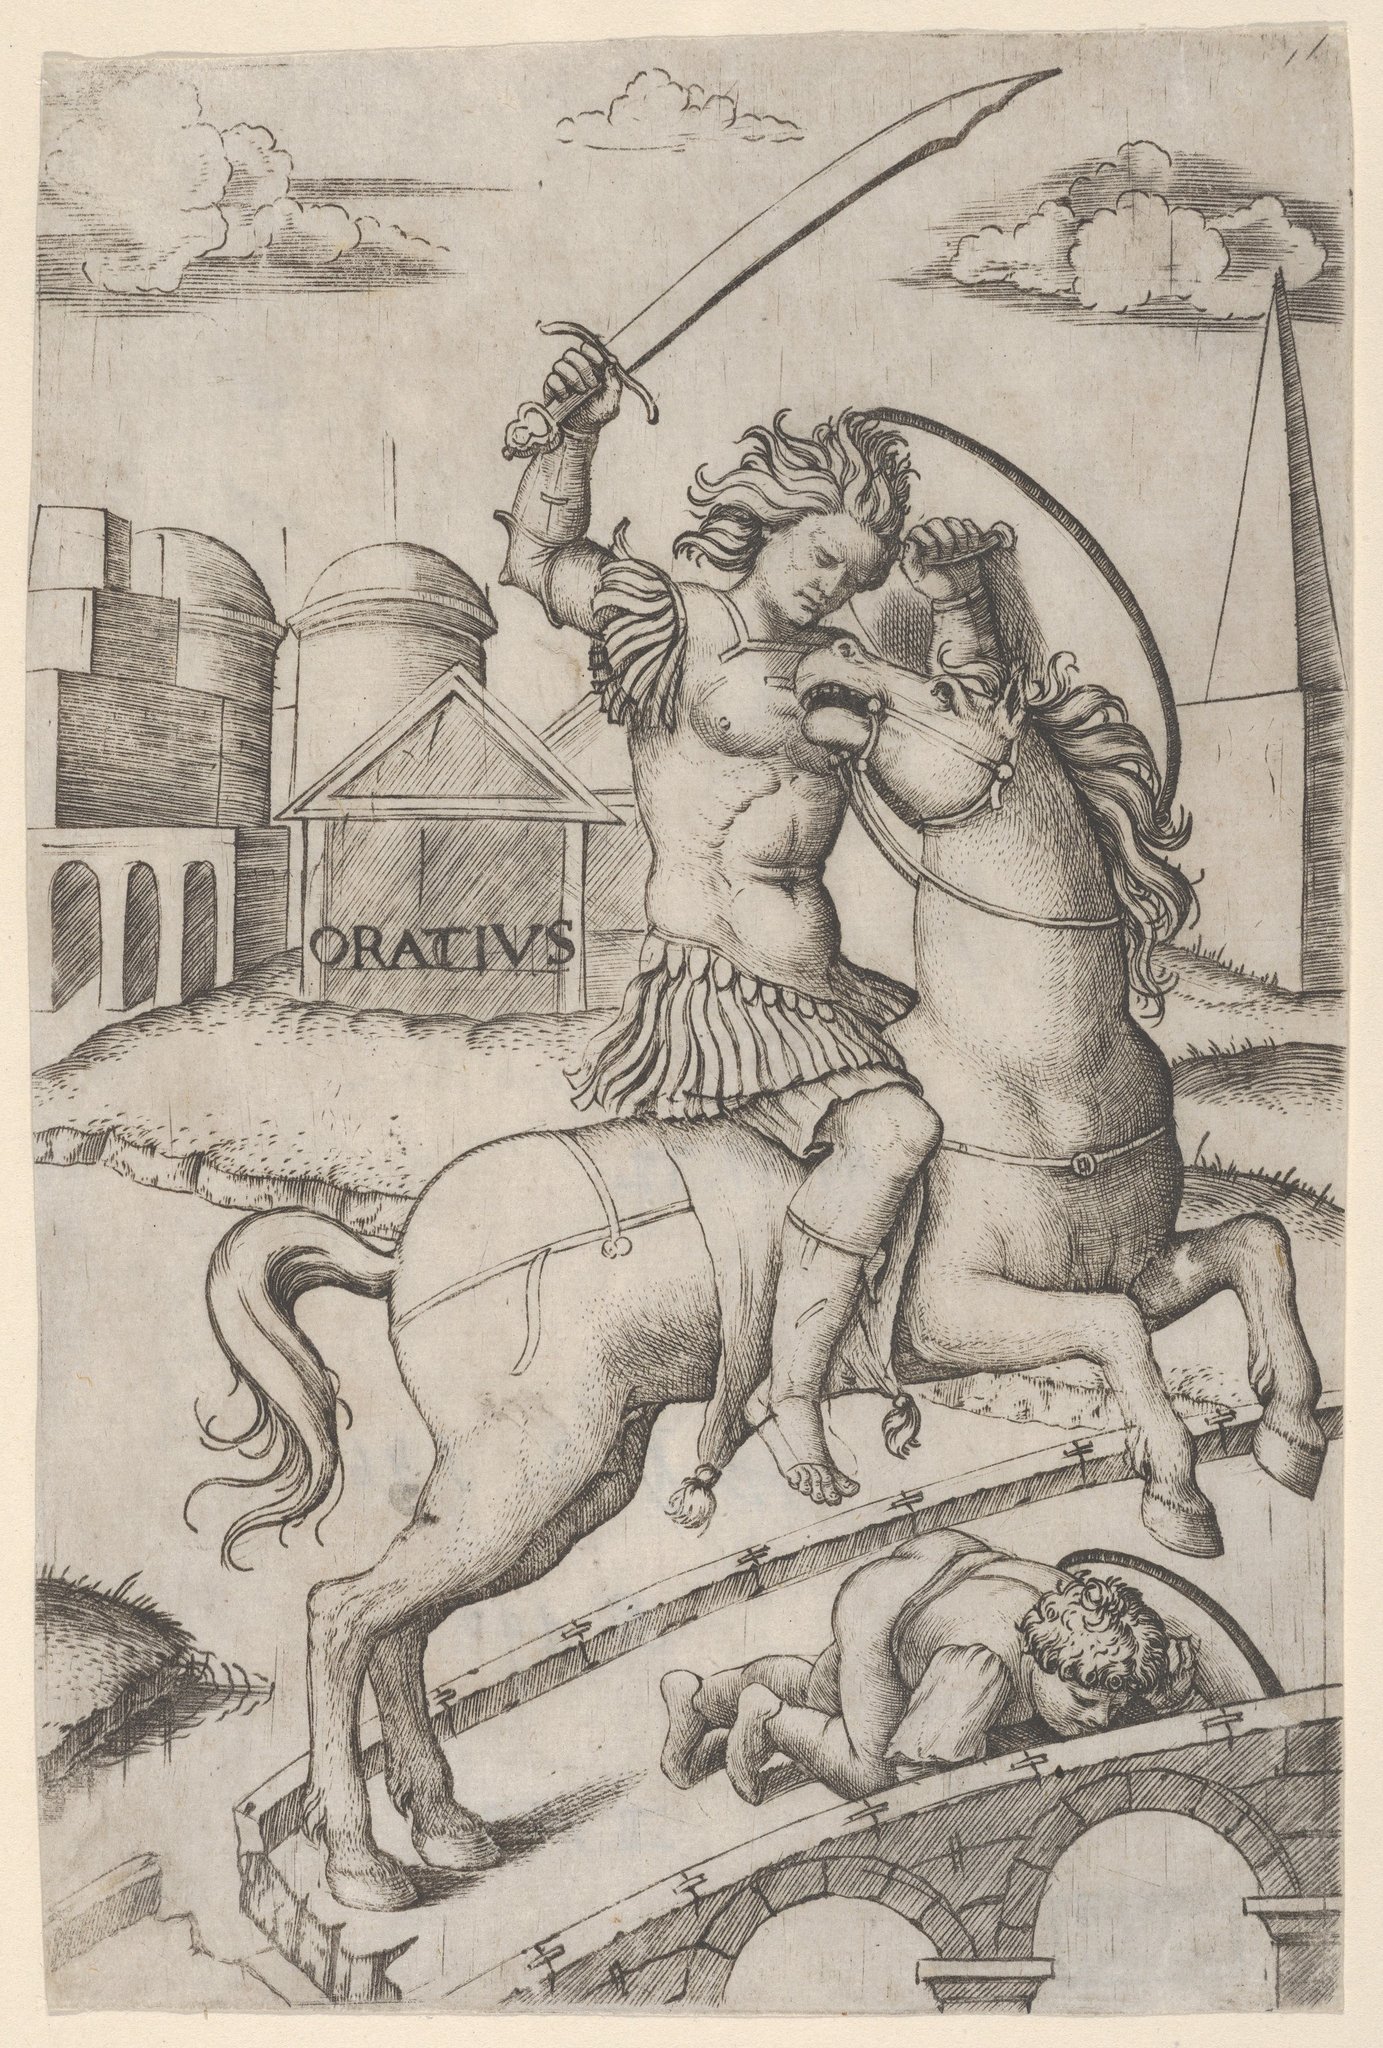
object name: print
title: Horatius Cocles on horseback, trampling a fallen soldier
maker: marcantonio raimondi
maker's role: artist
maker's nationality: italian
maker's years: 1475-1534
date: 1510-1527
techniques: engraving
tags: bridges,swords,boys,horses